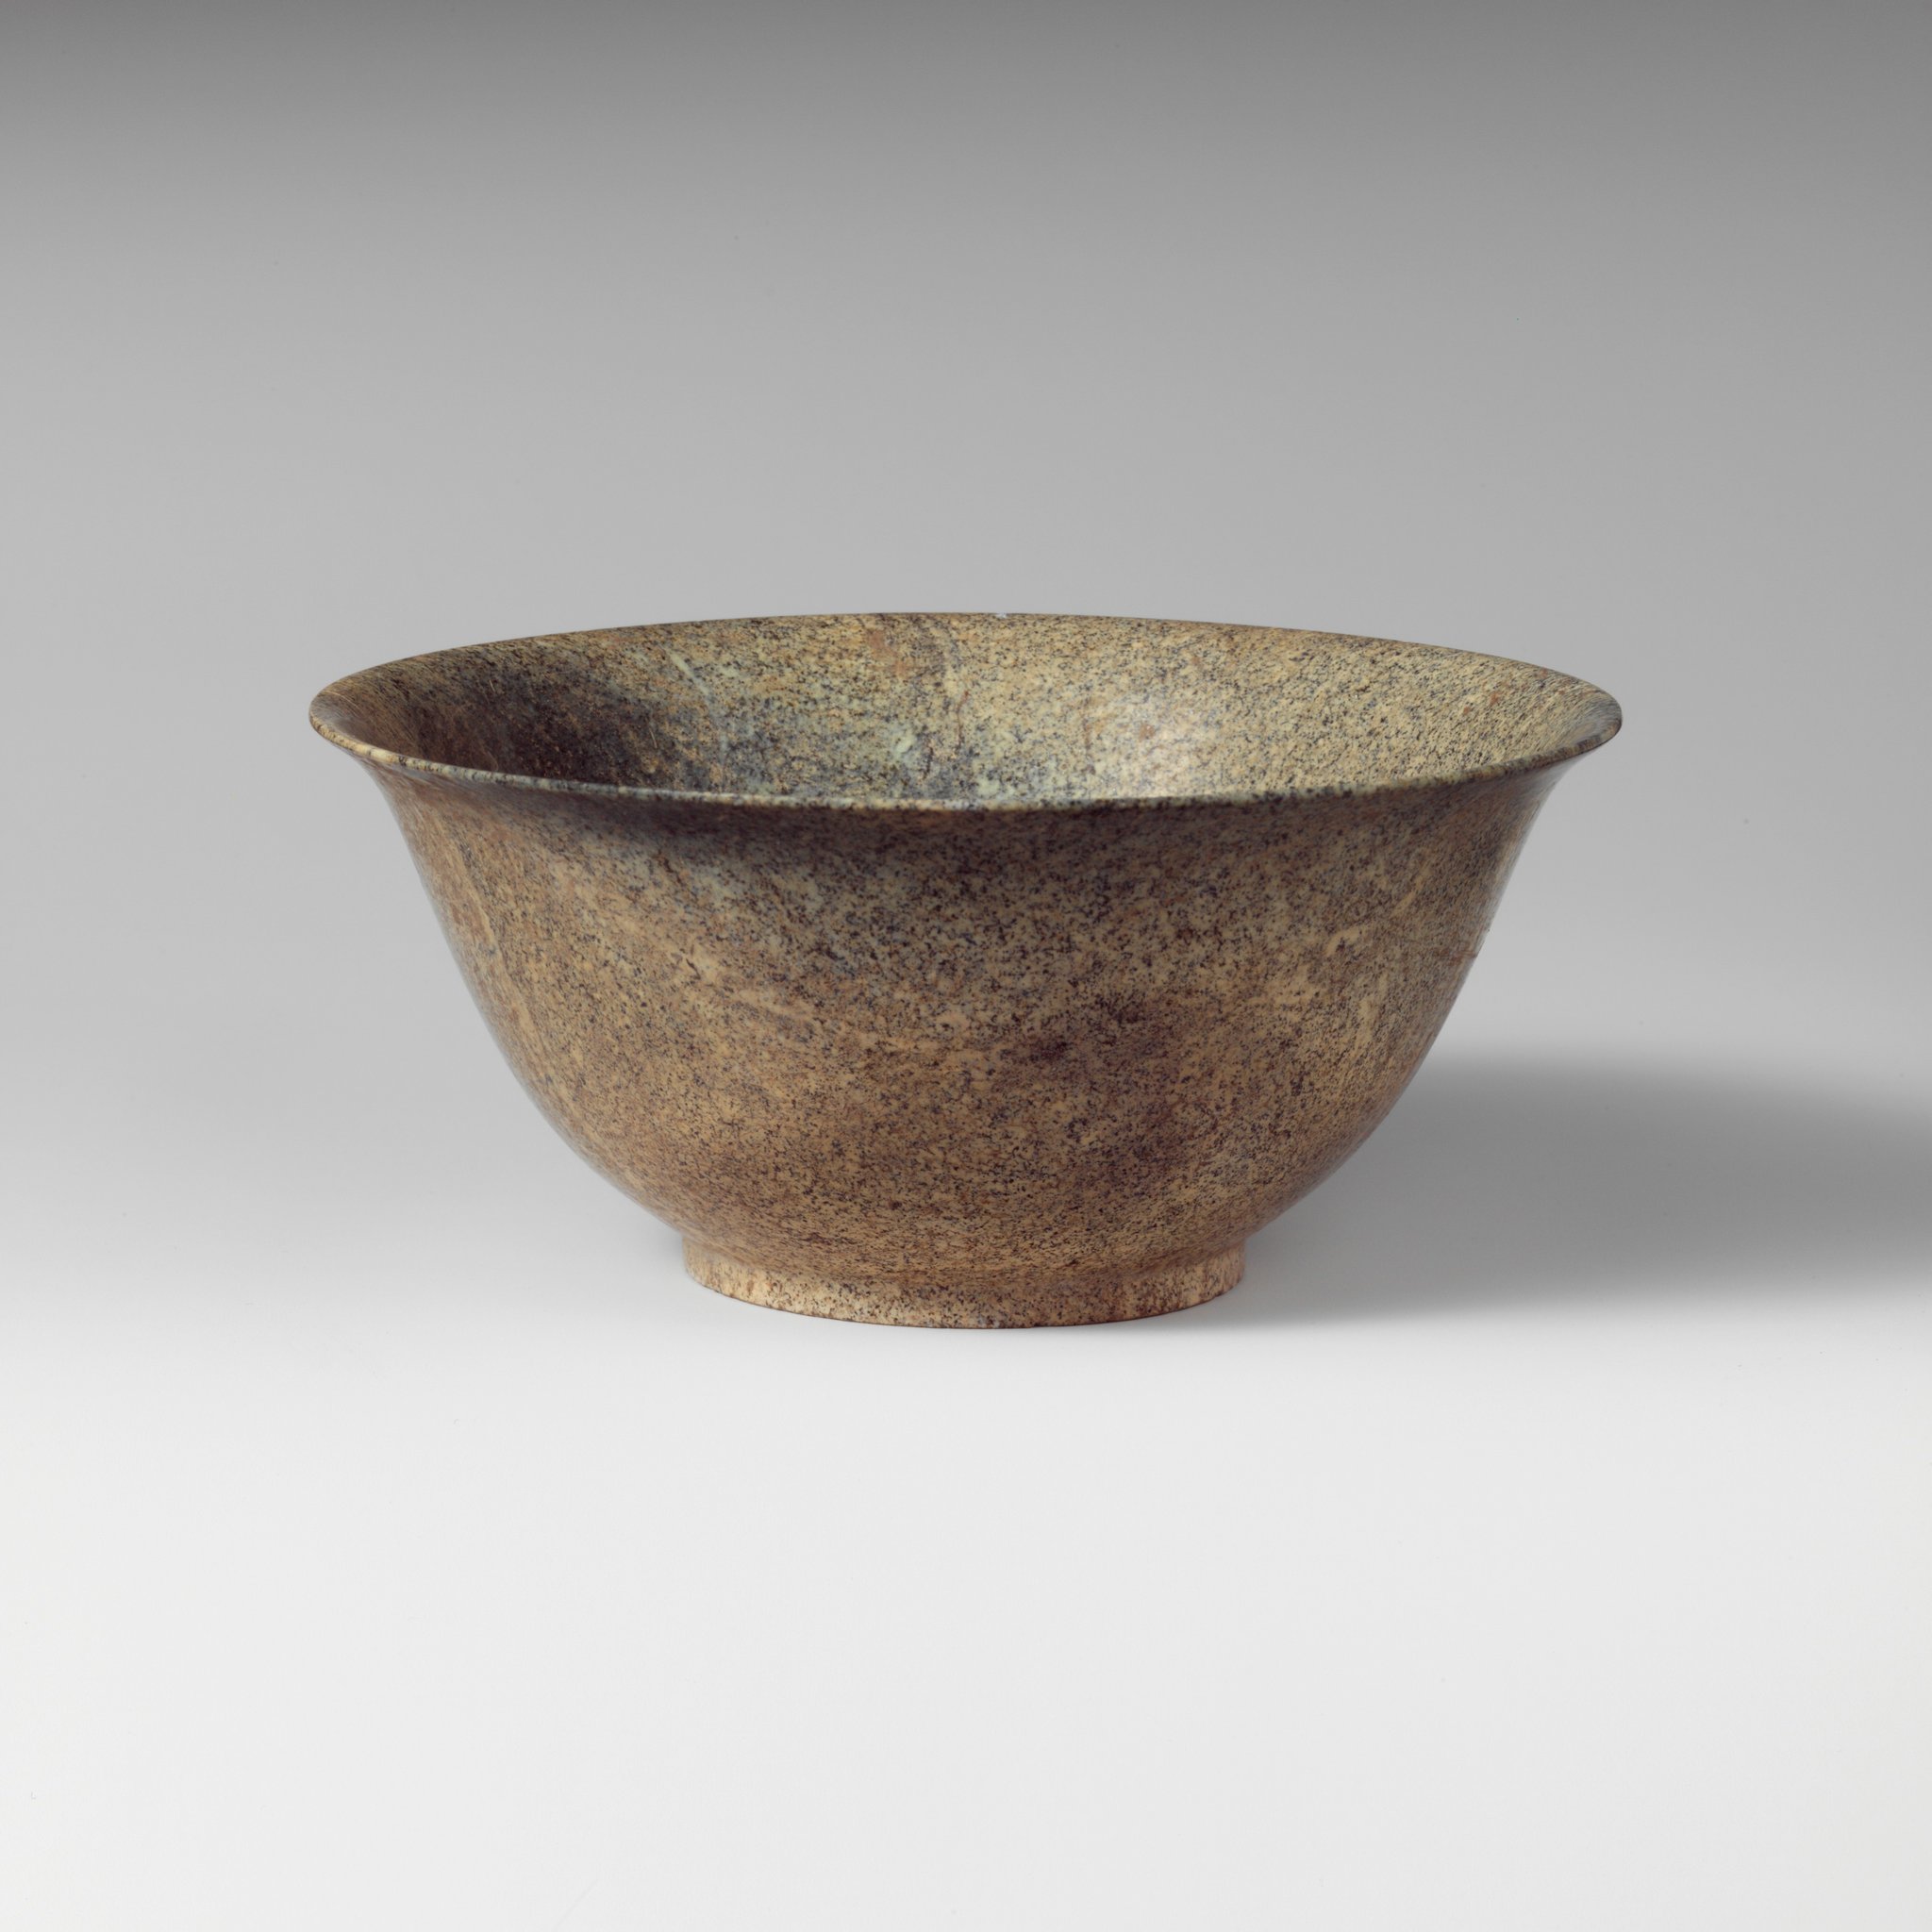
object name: bowl, shallow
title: Stone bowl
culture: roman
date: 100 BCE-100 CE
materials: granite